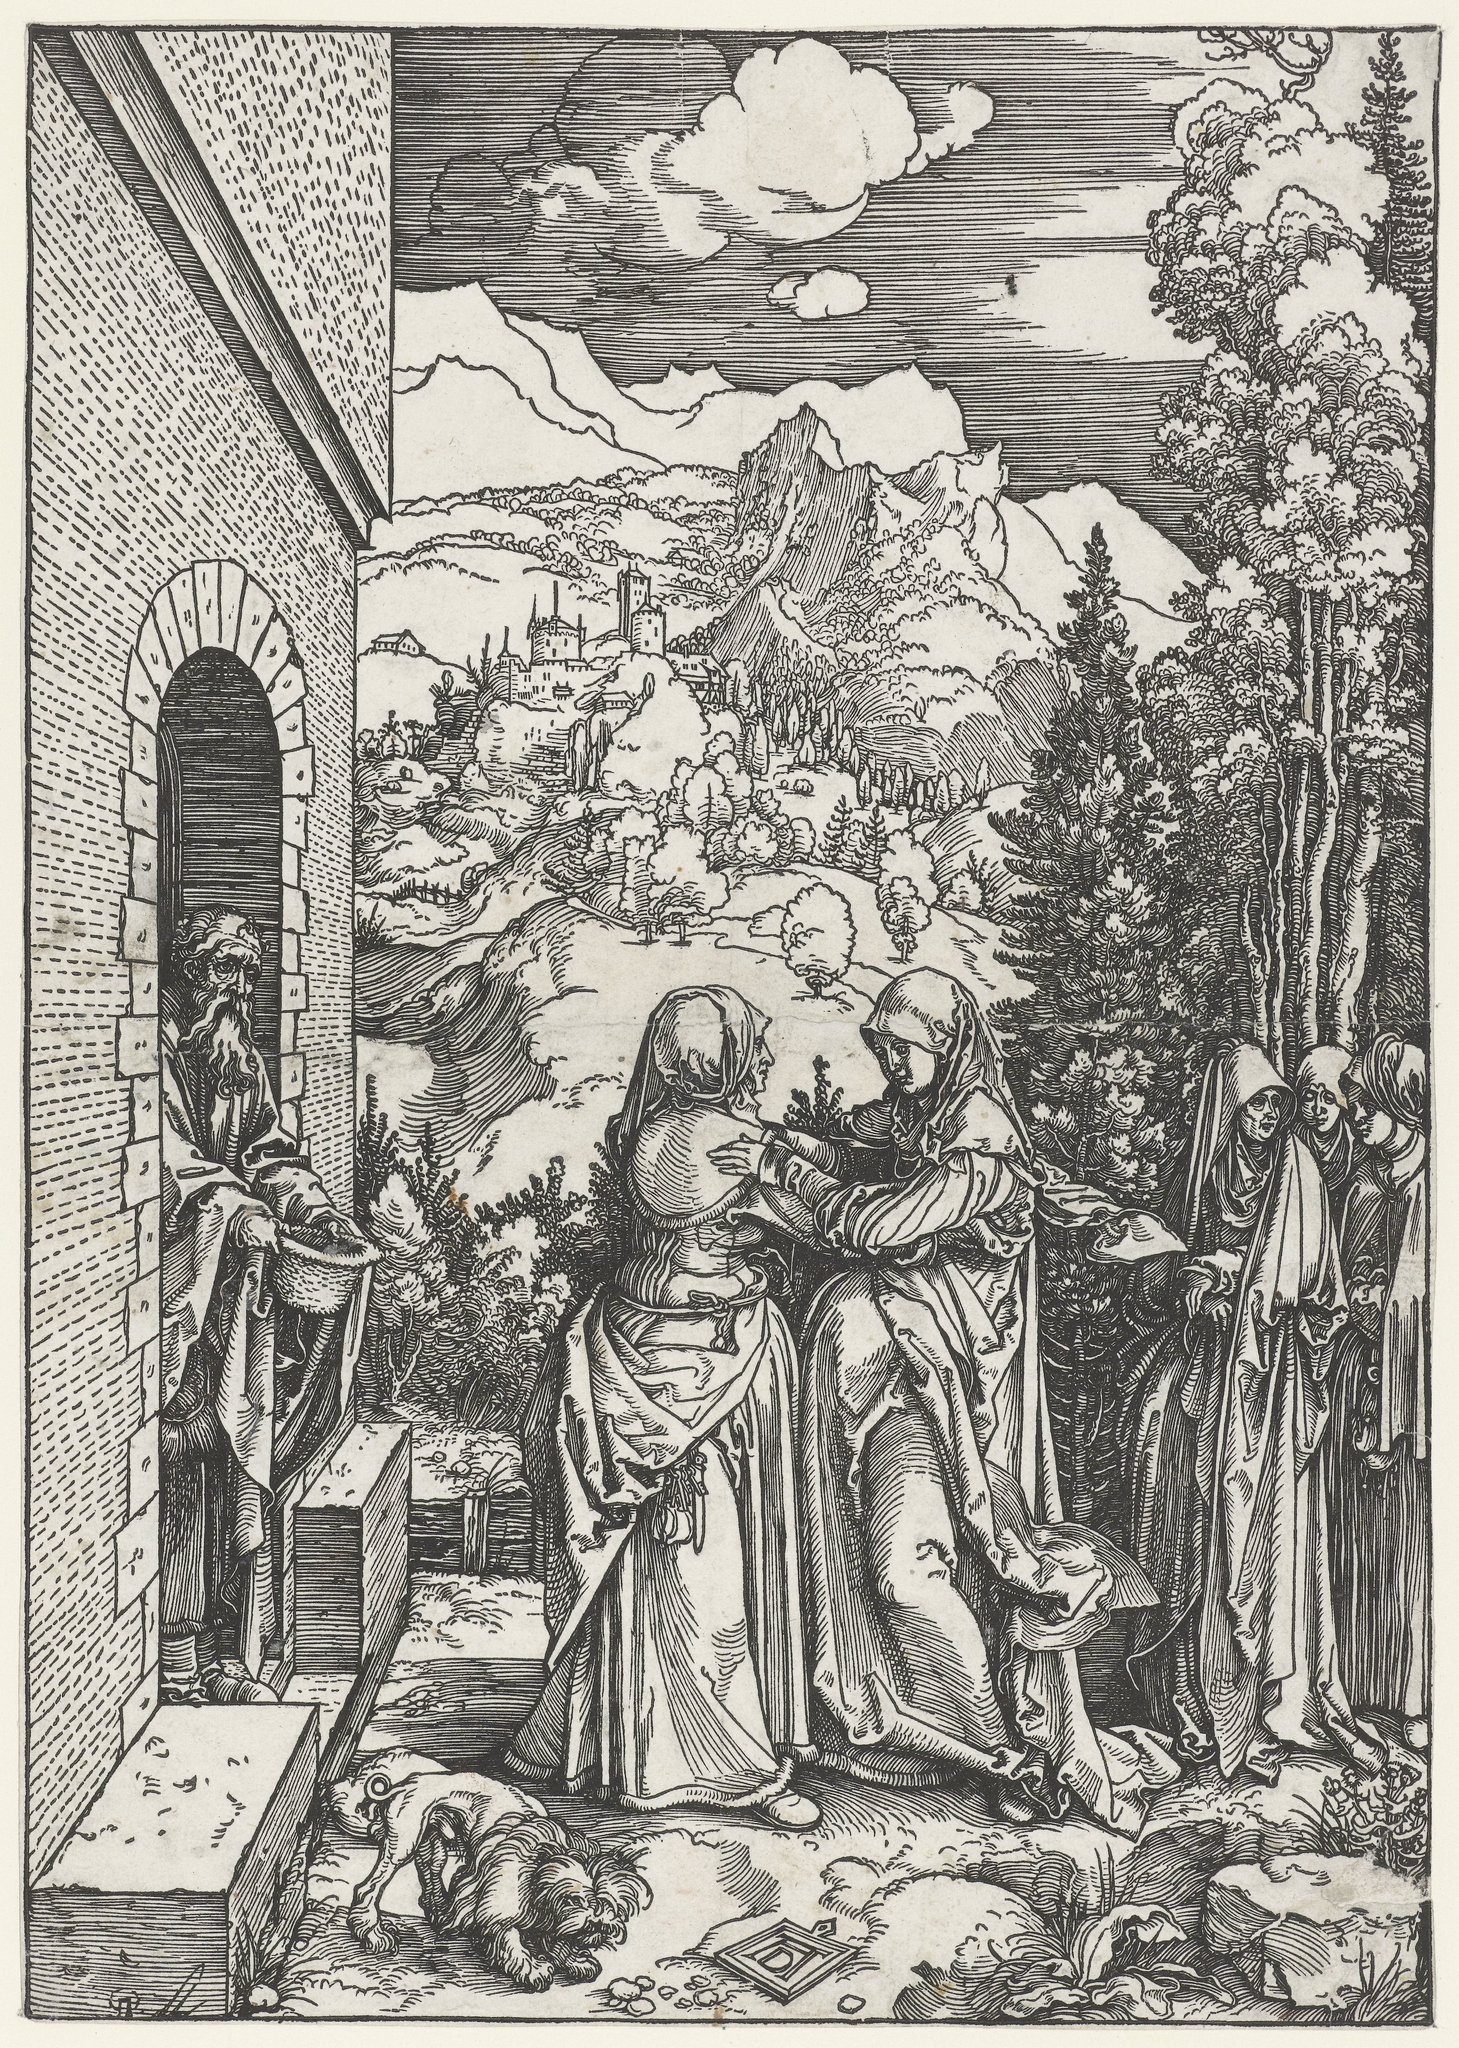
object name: print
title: Leven van Maria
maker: albrecht dürer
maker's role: draughtsman, painter, print maker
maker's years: 1471-1528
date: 1503-1504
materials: paper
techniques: woodcut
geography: nuremberg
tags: visitation (possibly joseph and/or zacharias present) (luke 1:39-56)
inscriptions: collector's mark: Lugt 240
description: Maria en Elizabeth, beiden net zwanger, ontmoeten elkaar bij een huis. Een man staat in de deuropening, een aantal vrouwen staan achter Maria en Elizabeth. Op de achtergrond een berglandschap. Deze prent is onderdeel van een serie van 20 prenten, bestaand uit een titelprent en 19 prenten met scènes uit het leven van Maria.